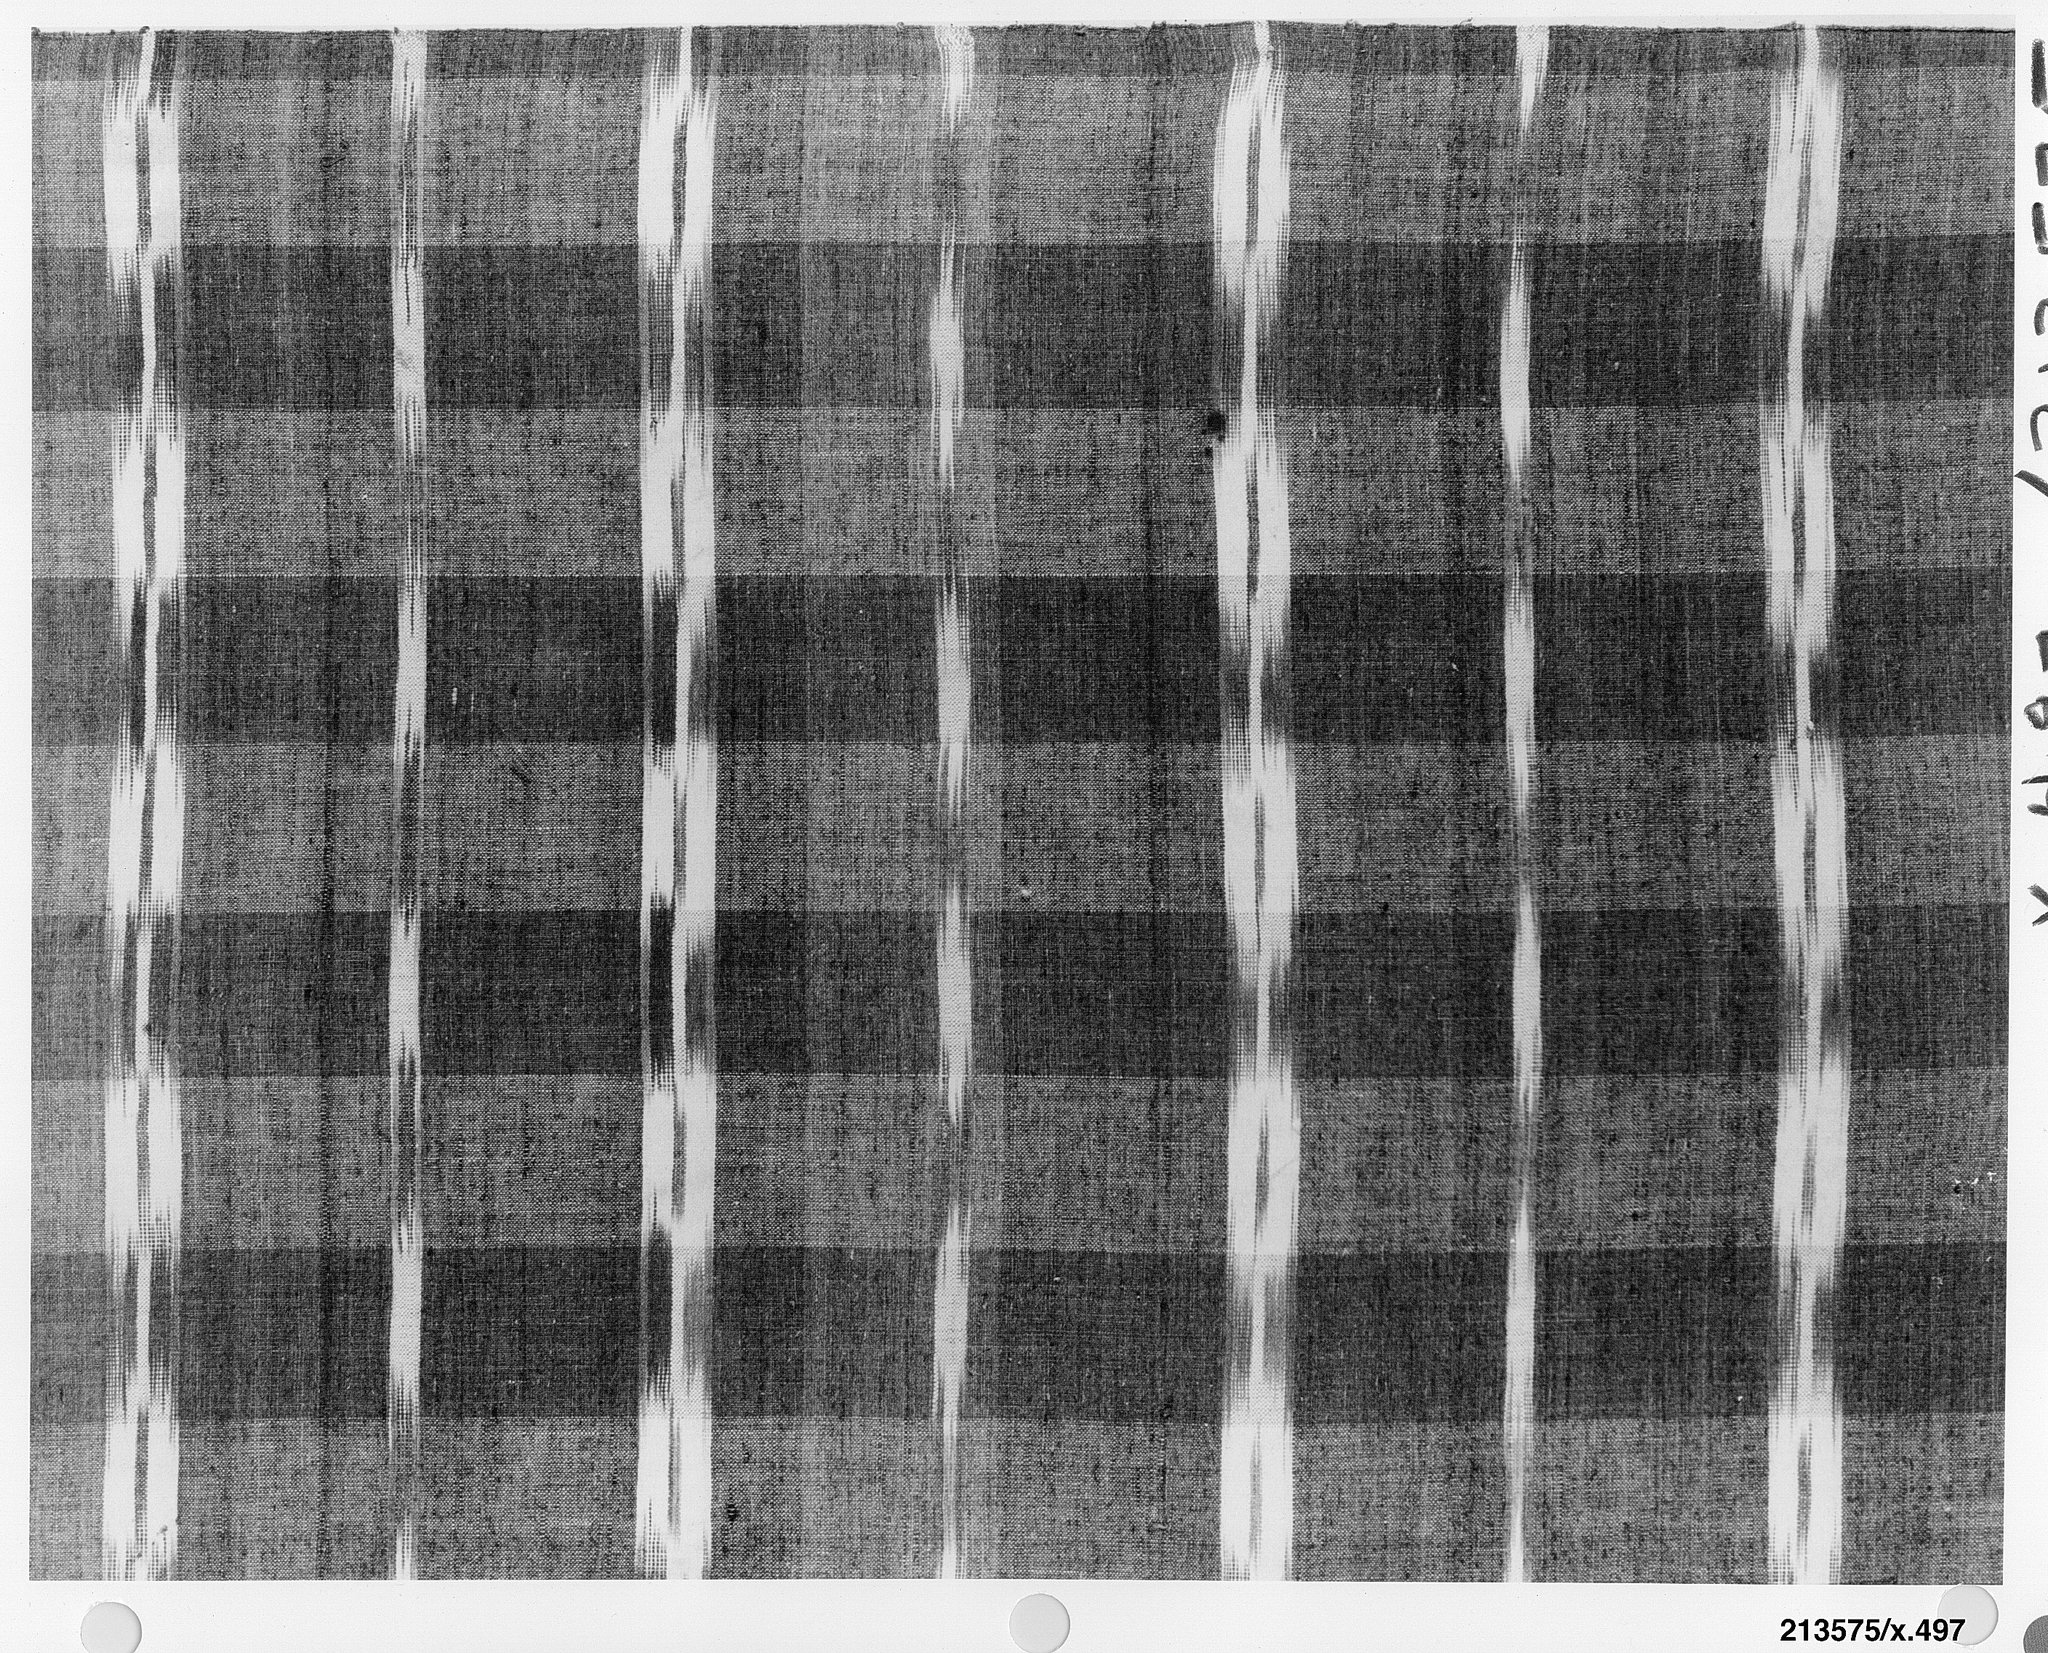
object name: piece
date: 1701-1800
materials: cotton